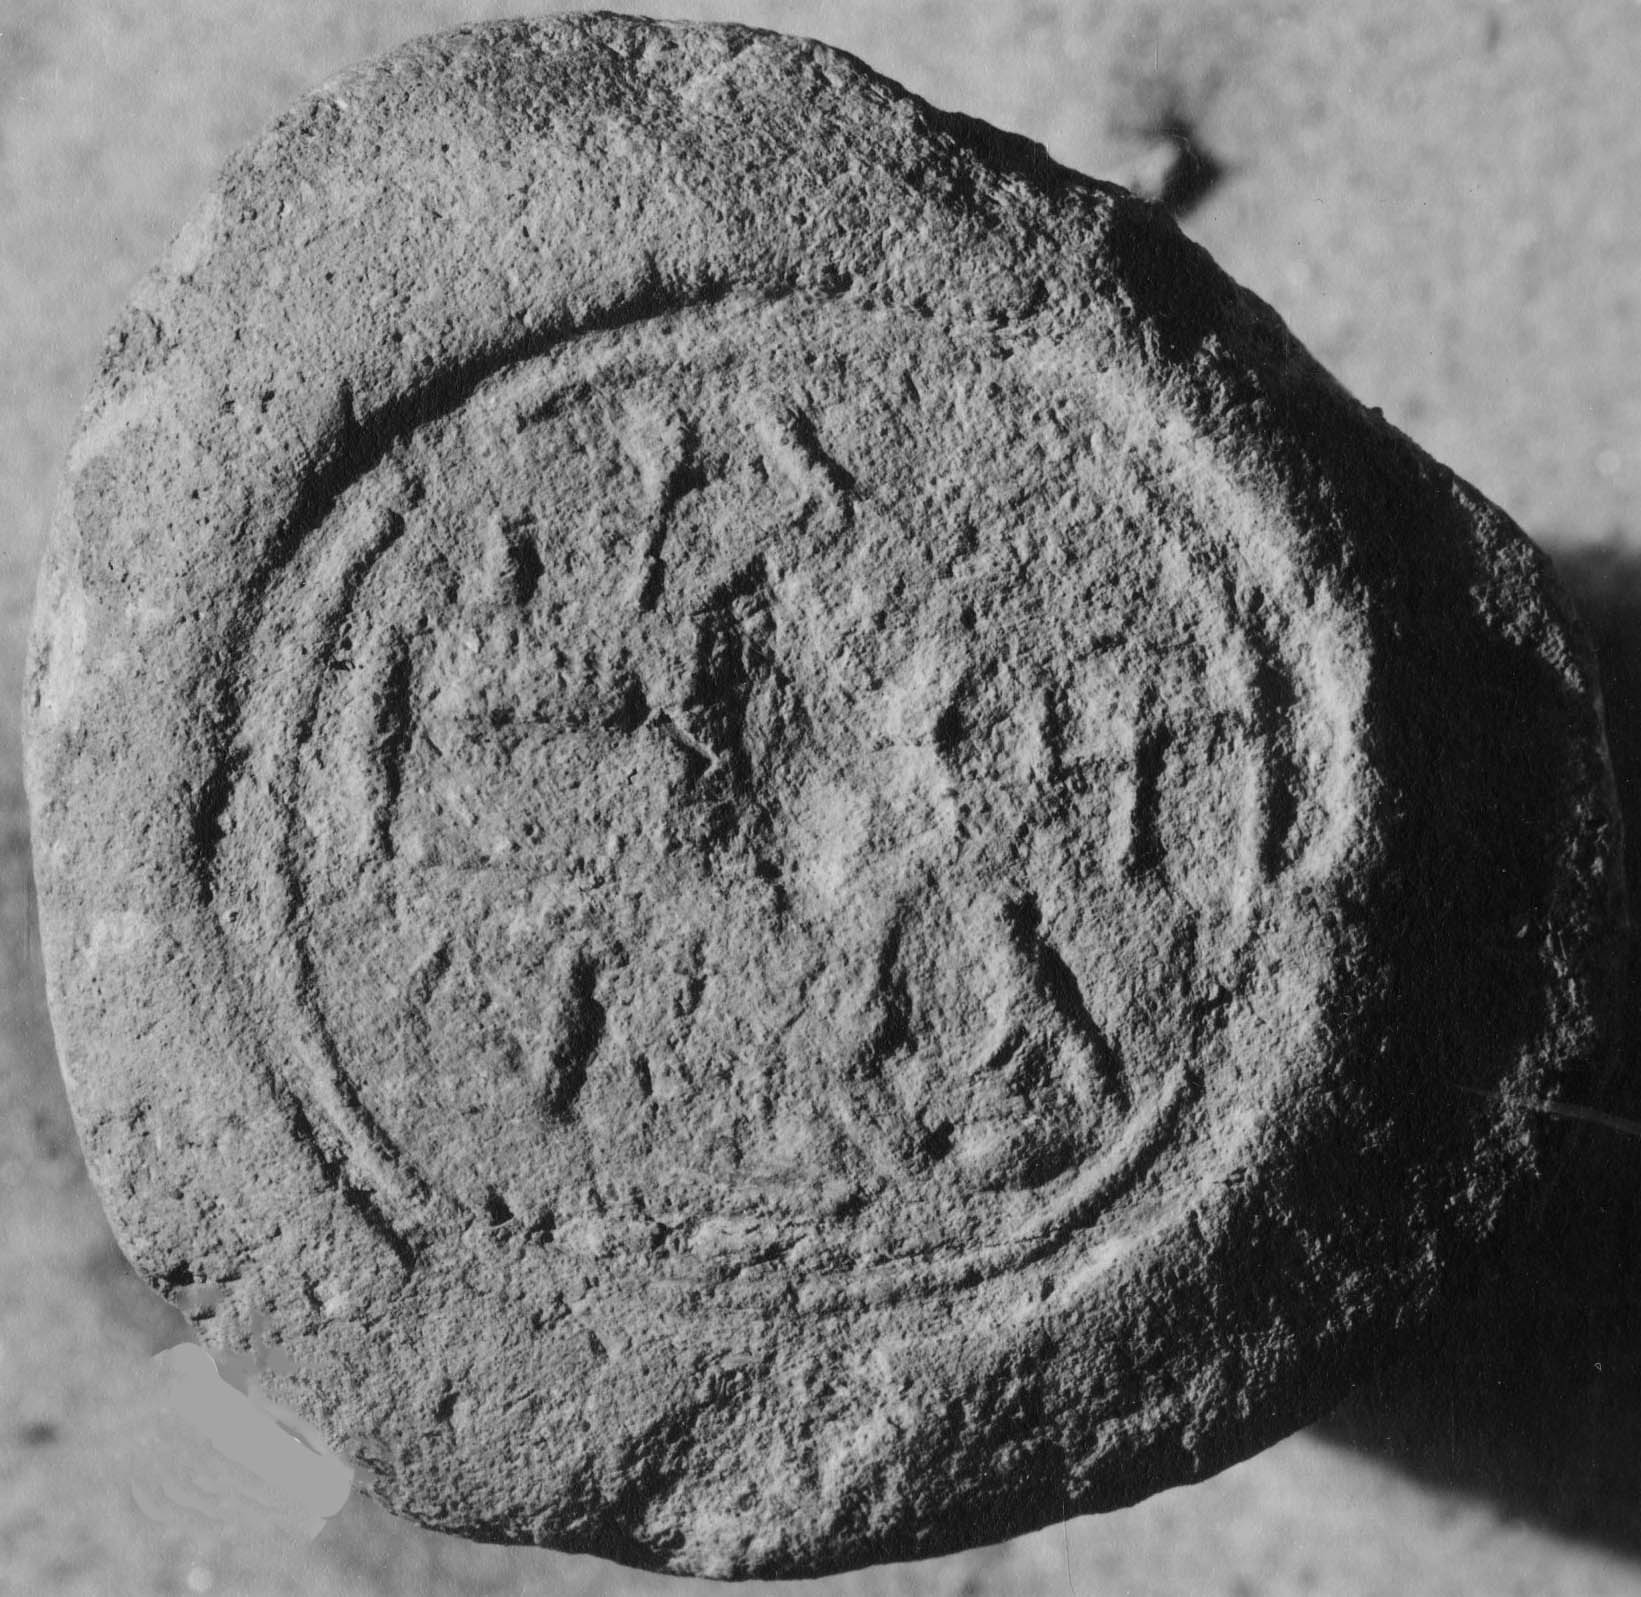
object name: cone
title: Funerary Cone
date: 1550-1295 BCE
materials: pottery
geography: egypt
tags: hieroglyphs